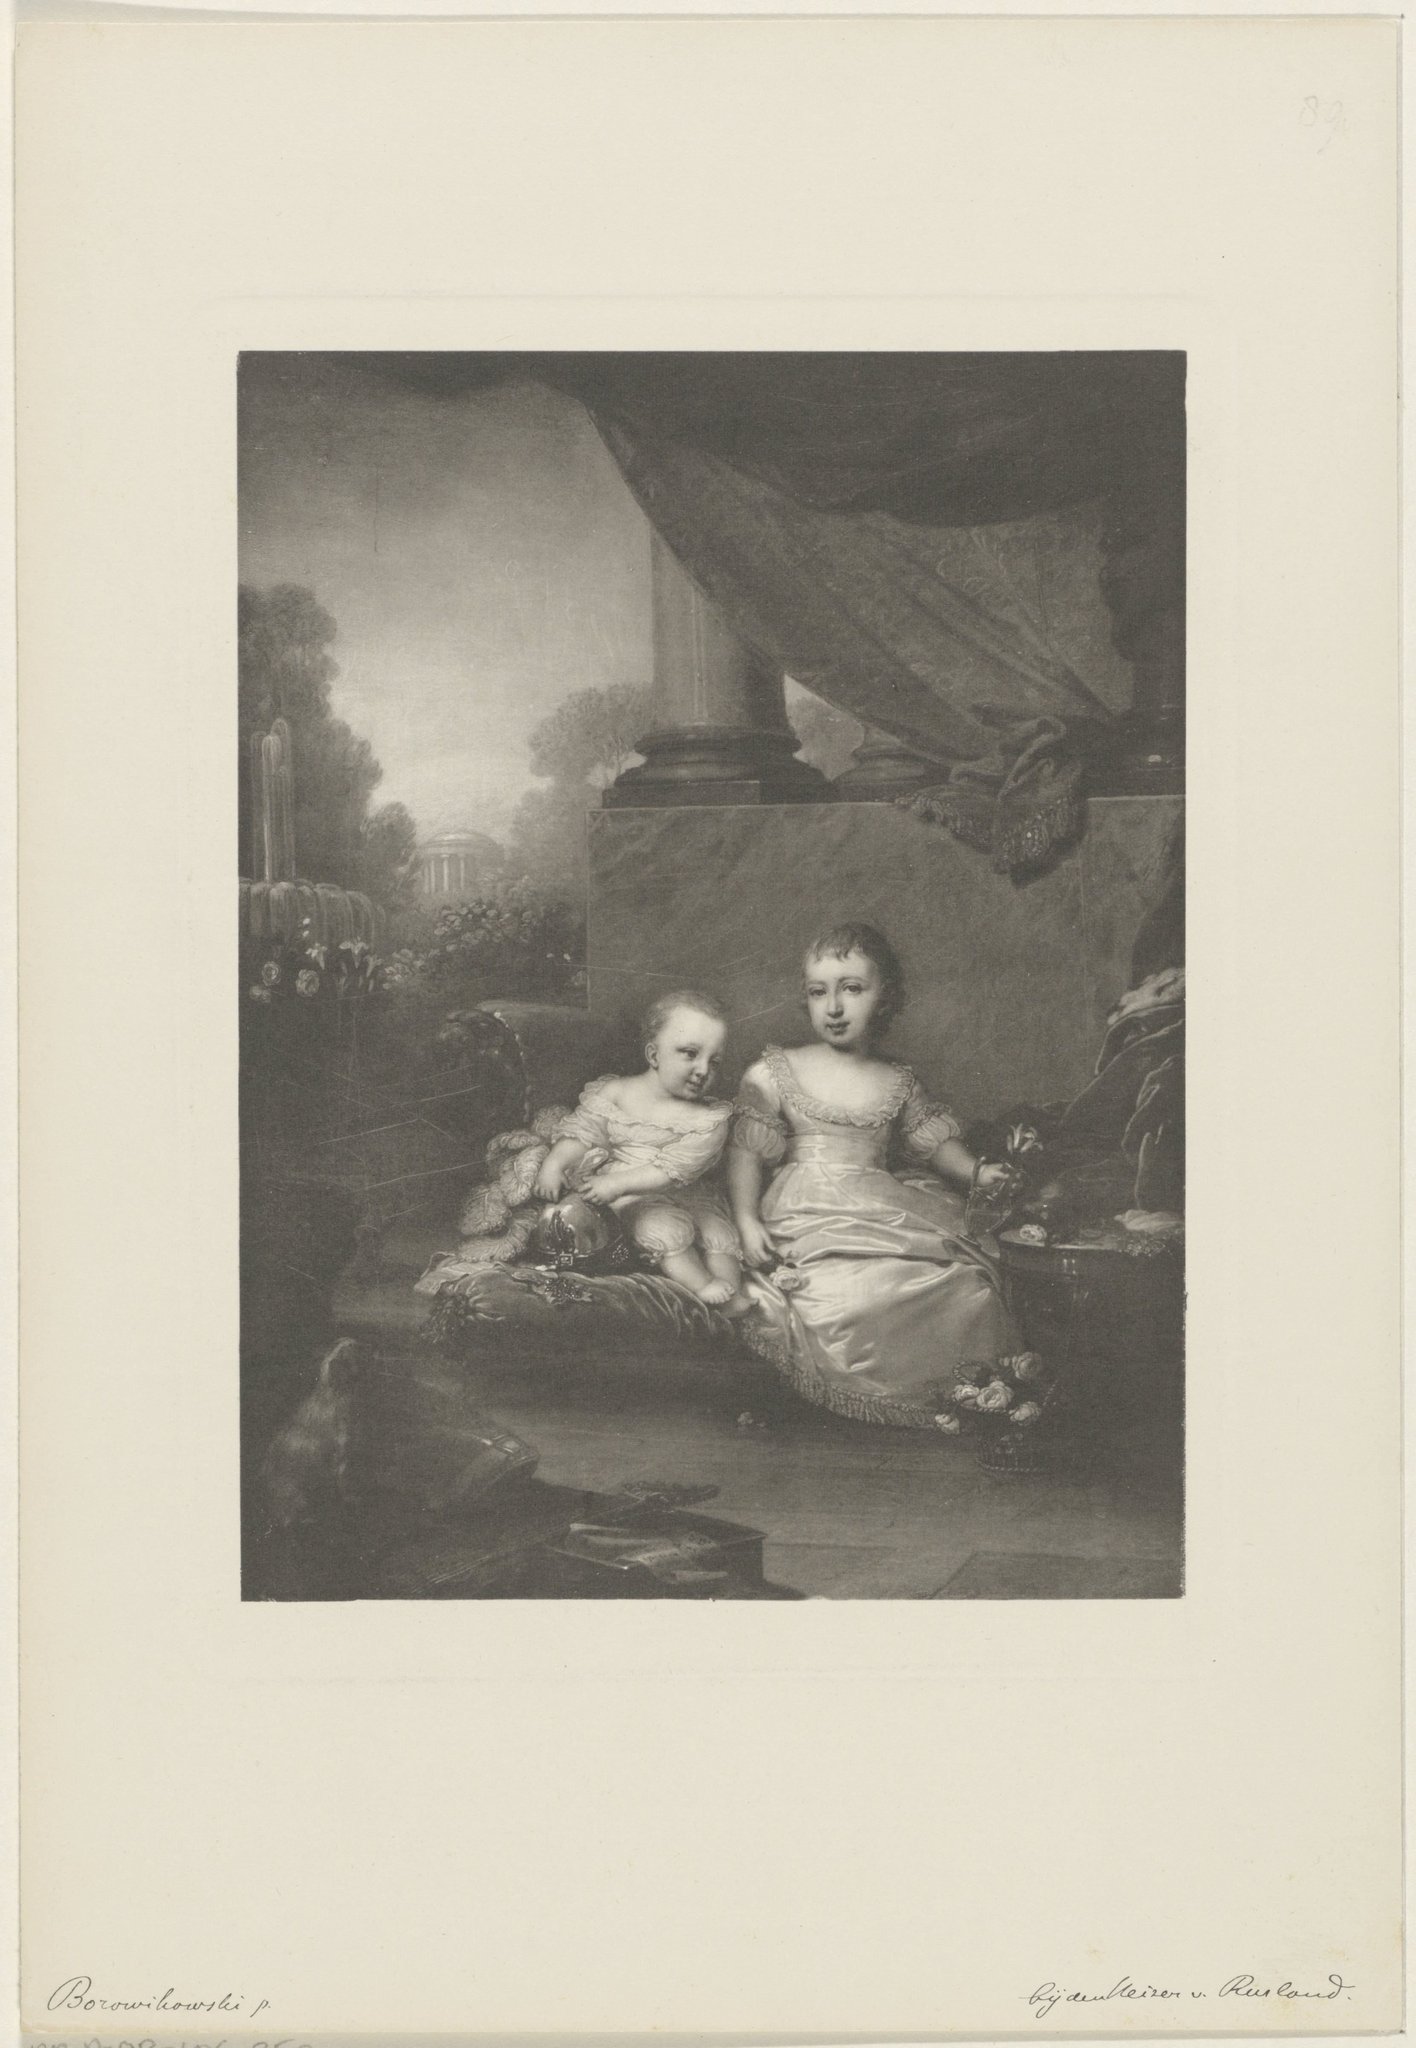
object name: photomechanical print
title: Portret van Anna Paulowna Romanowa en Nicolaas I Pavlovitsj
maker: Anonymous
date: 1850-1949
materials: paper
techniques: photograph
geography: netherlands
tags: anna paulowna romanowa